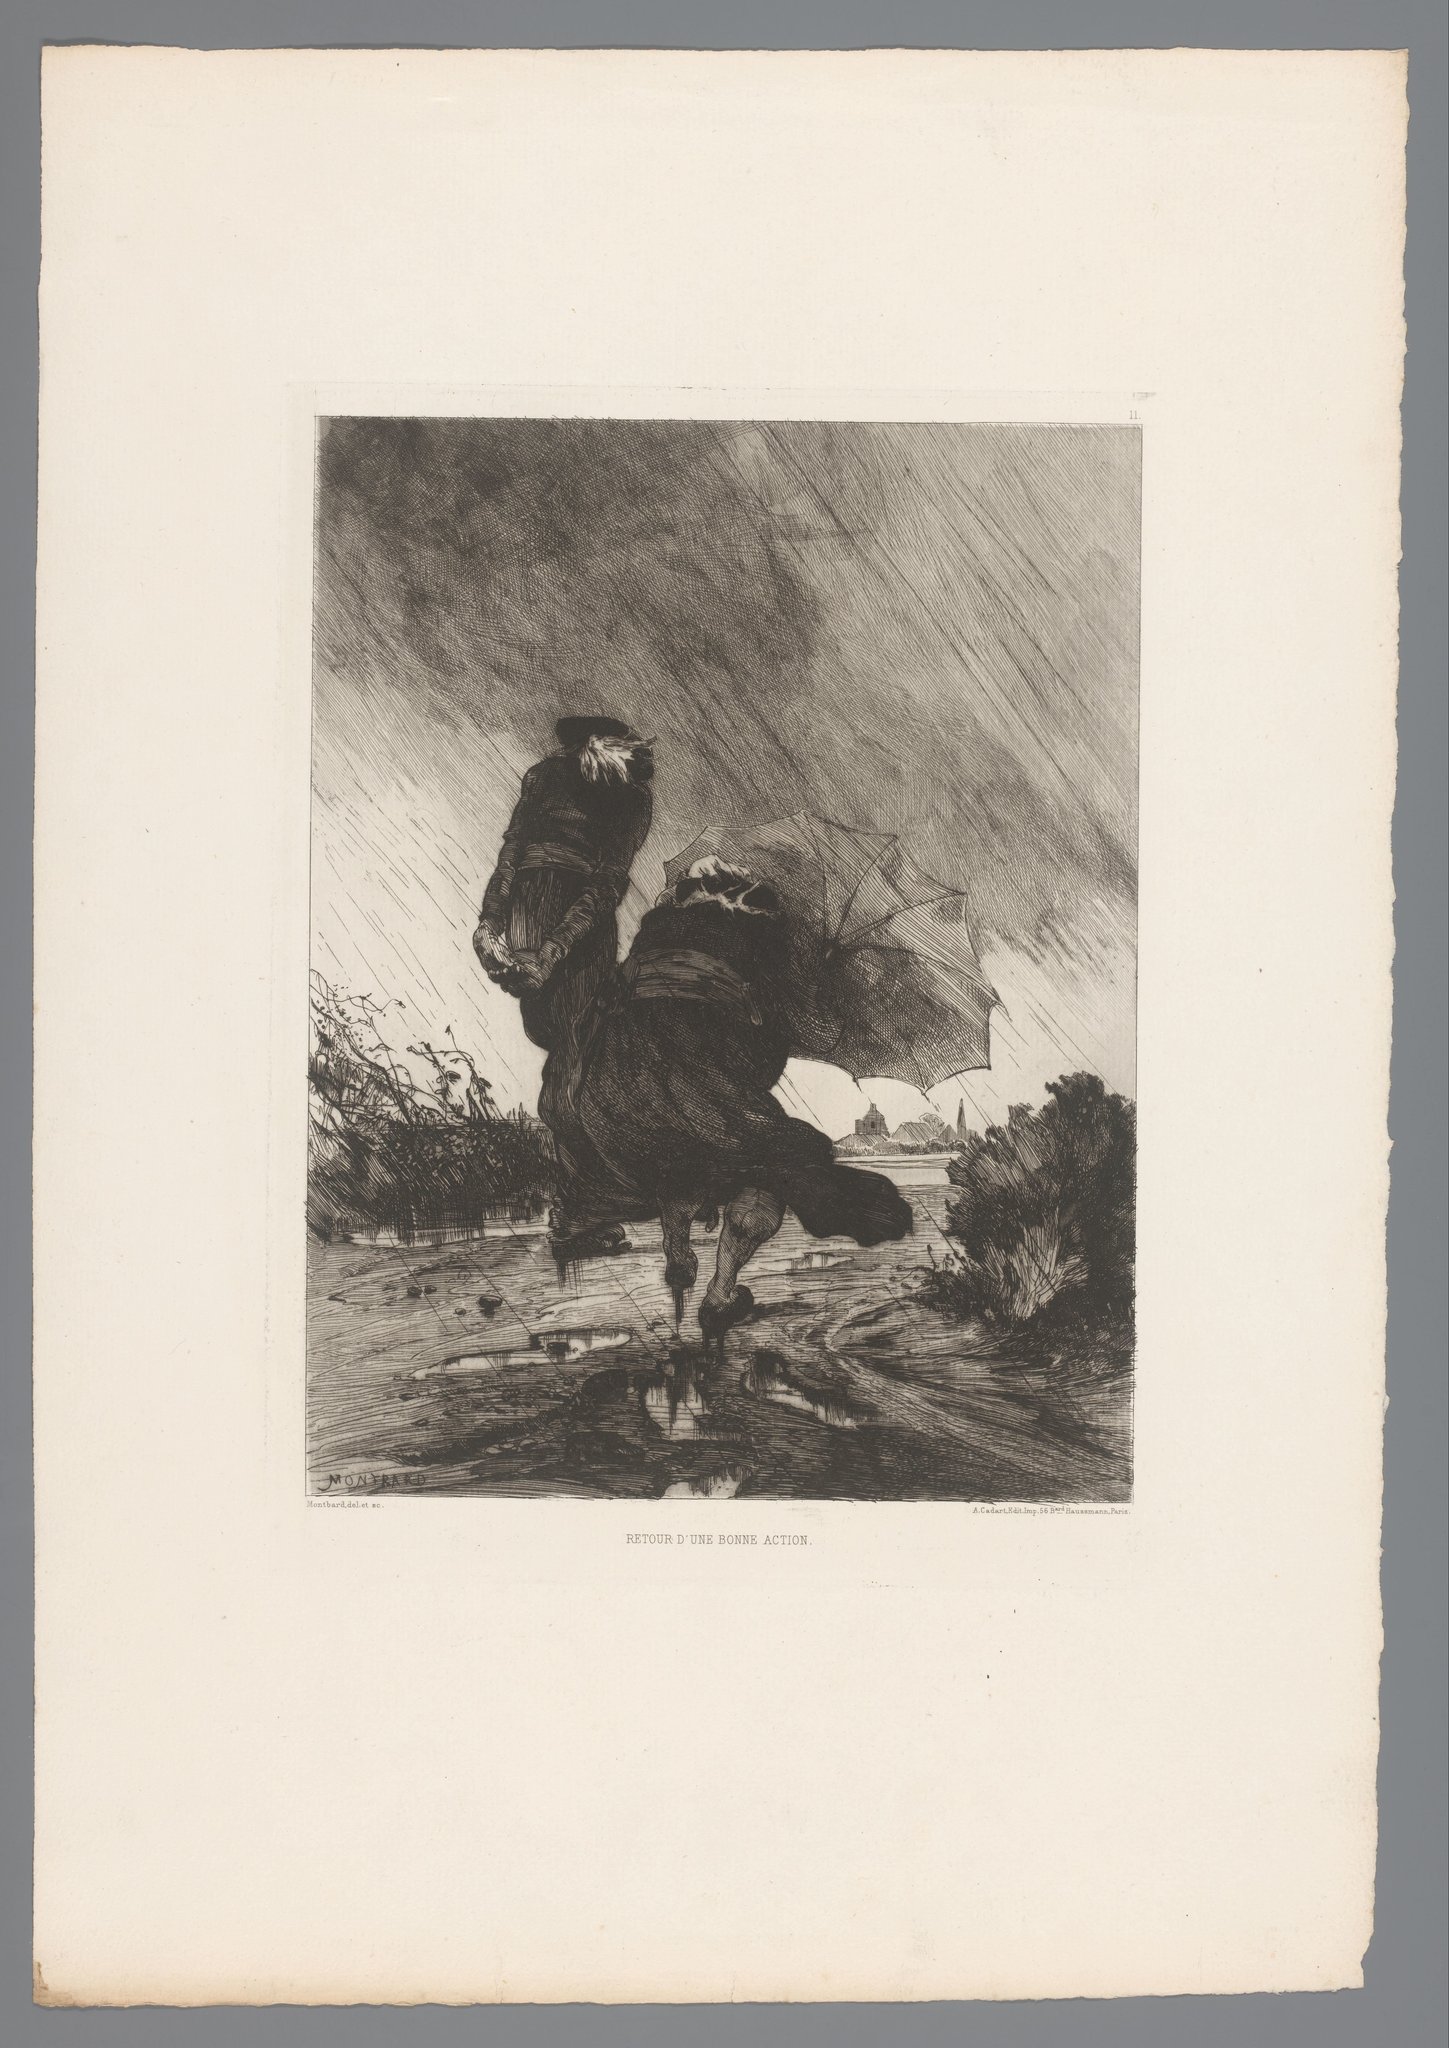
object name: print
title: L'eau-forte en 1875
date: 1875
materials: paper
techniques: drypoint, etching, intaglio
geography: paris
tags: downpour, rain shower, umbrella, charitable works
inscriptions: collector's mark: Lugt 2760, collector's mark: ‘AFE v S’, collector's mark: Lugt 2228